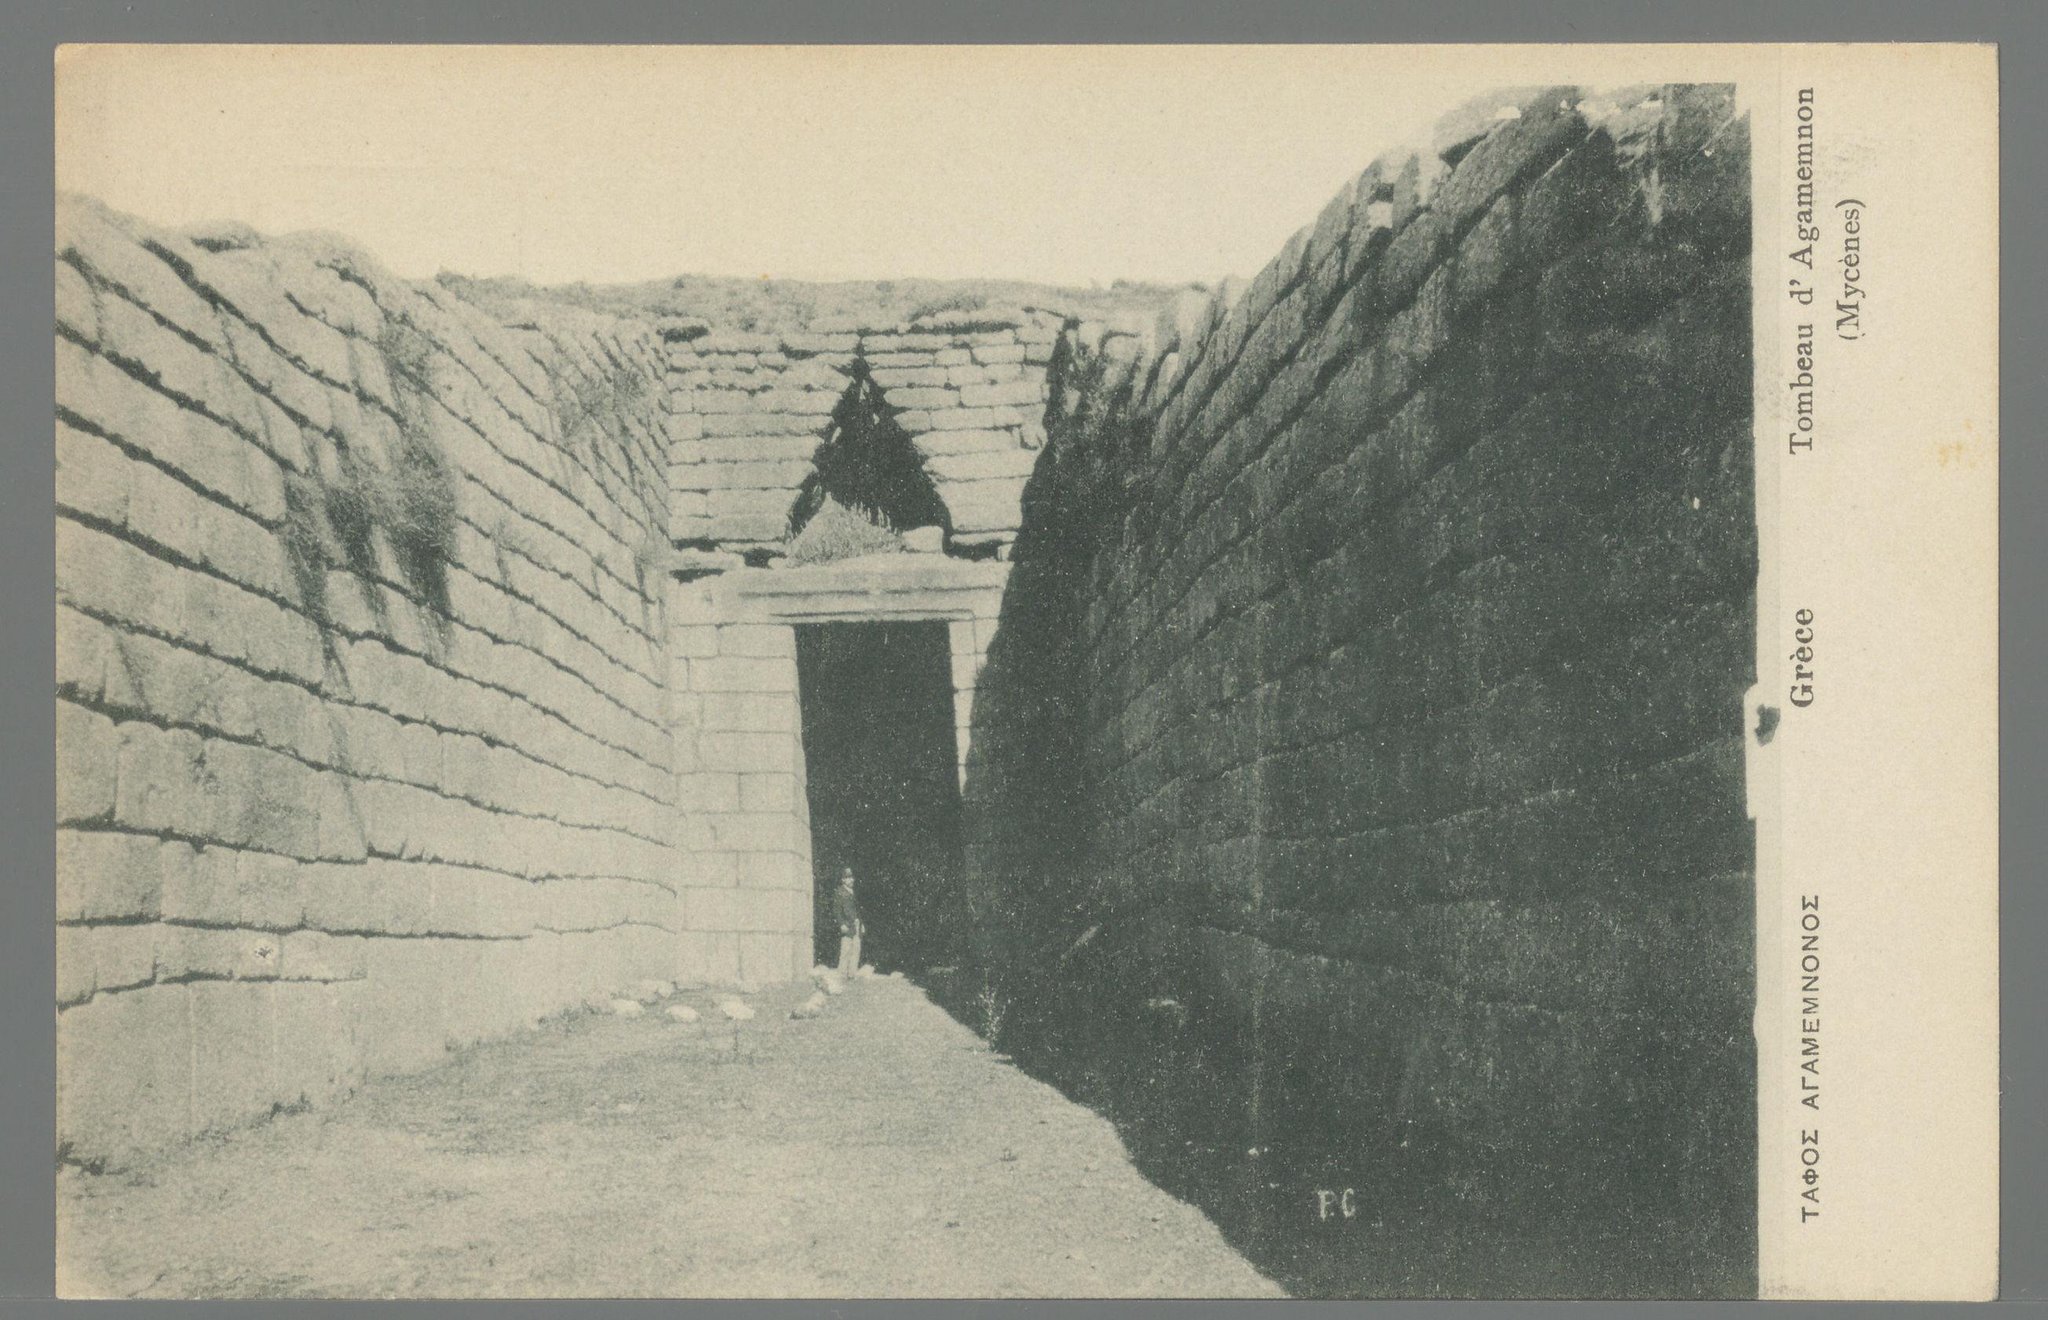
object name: photomechanical print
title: Grèce. Tombeau d'Agamemnon (Mycène)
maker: Anonymous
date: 1906-1930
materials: cardboard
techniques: photograph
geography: athens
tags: grave, tomb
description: Voor de Franse titel staat de titel in het Grieks.